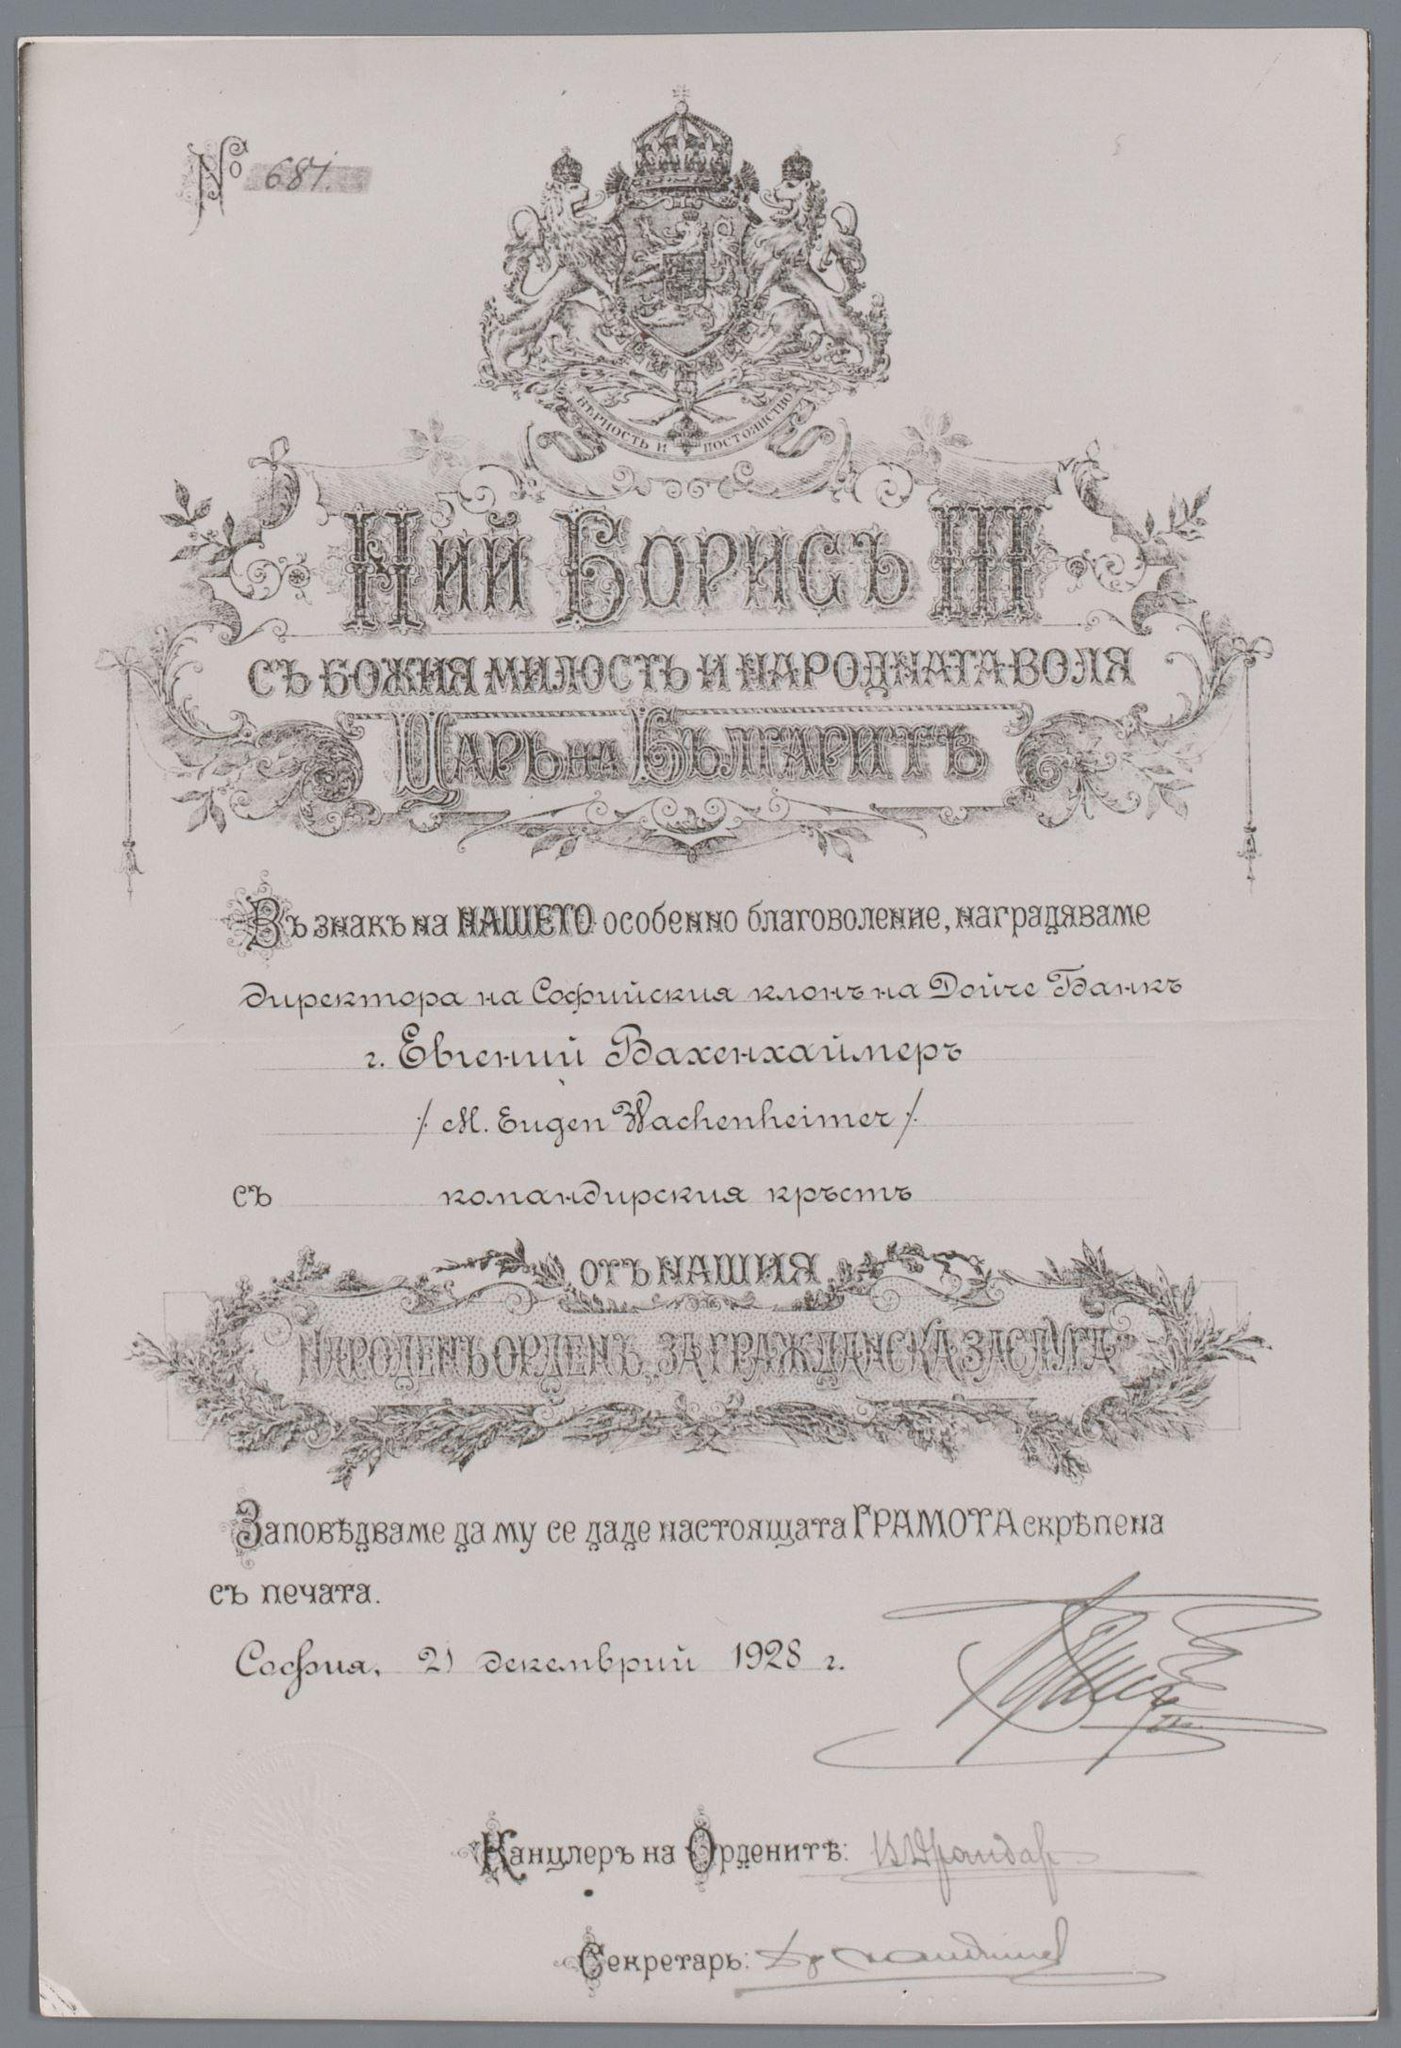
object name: bewijs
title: Getuigschriften van Eugen Wachenheimer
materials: paper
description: Dit object is onderdeel van de nalatenschap van Isabel Elon-Wachenheimer (1928-2010). Tot haar overlijden behoorde het samen met de andere objecten uit de nalatenschap tot haar privédomein van Isabel Wachenheimer. In die particuliere context zijn deze objecten tezamen en individueel aandenkens - aan de jeugd, ouders en familie van Isabel Wachenheimer vóór en tijdens de Shoah en aan haar leven na de Tweede Wereldoorlog. Isabel Wachenheimer, die van juni 1943 tot mei 1945 gevangen zat in Kamp Westerbork, Theresienstadt, Auschwitz, Lenzing a/d Oberdonau (een buitenkamp van Mauthausen), overleefde de Shoah. Haar ouders – Eugène Wachenheimer en Else Wachenheimer-Moos - werden op 14 oktober 1944 in Auschwitz-Birkenau vermoord.